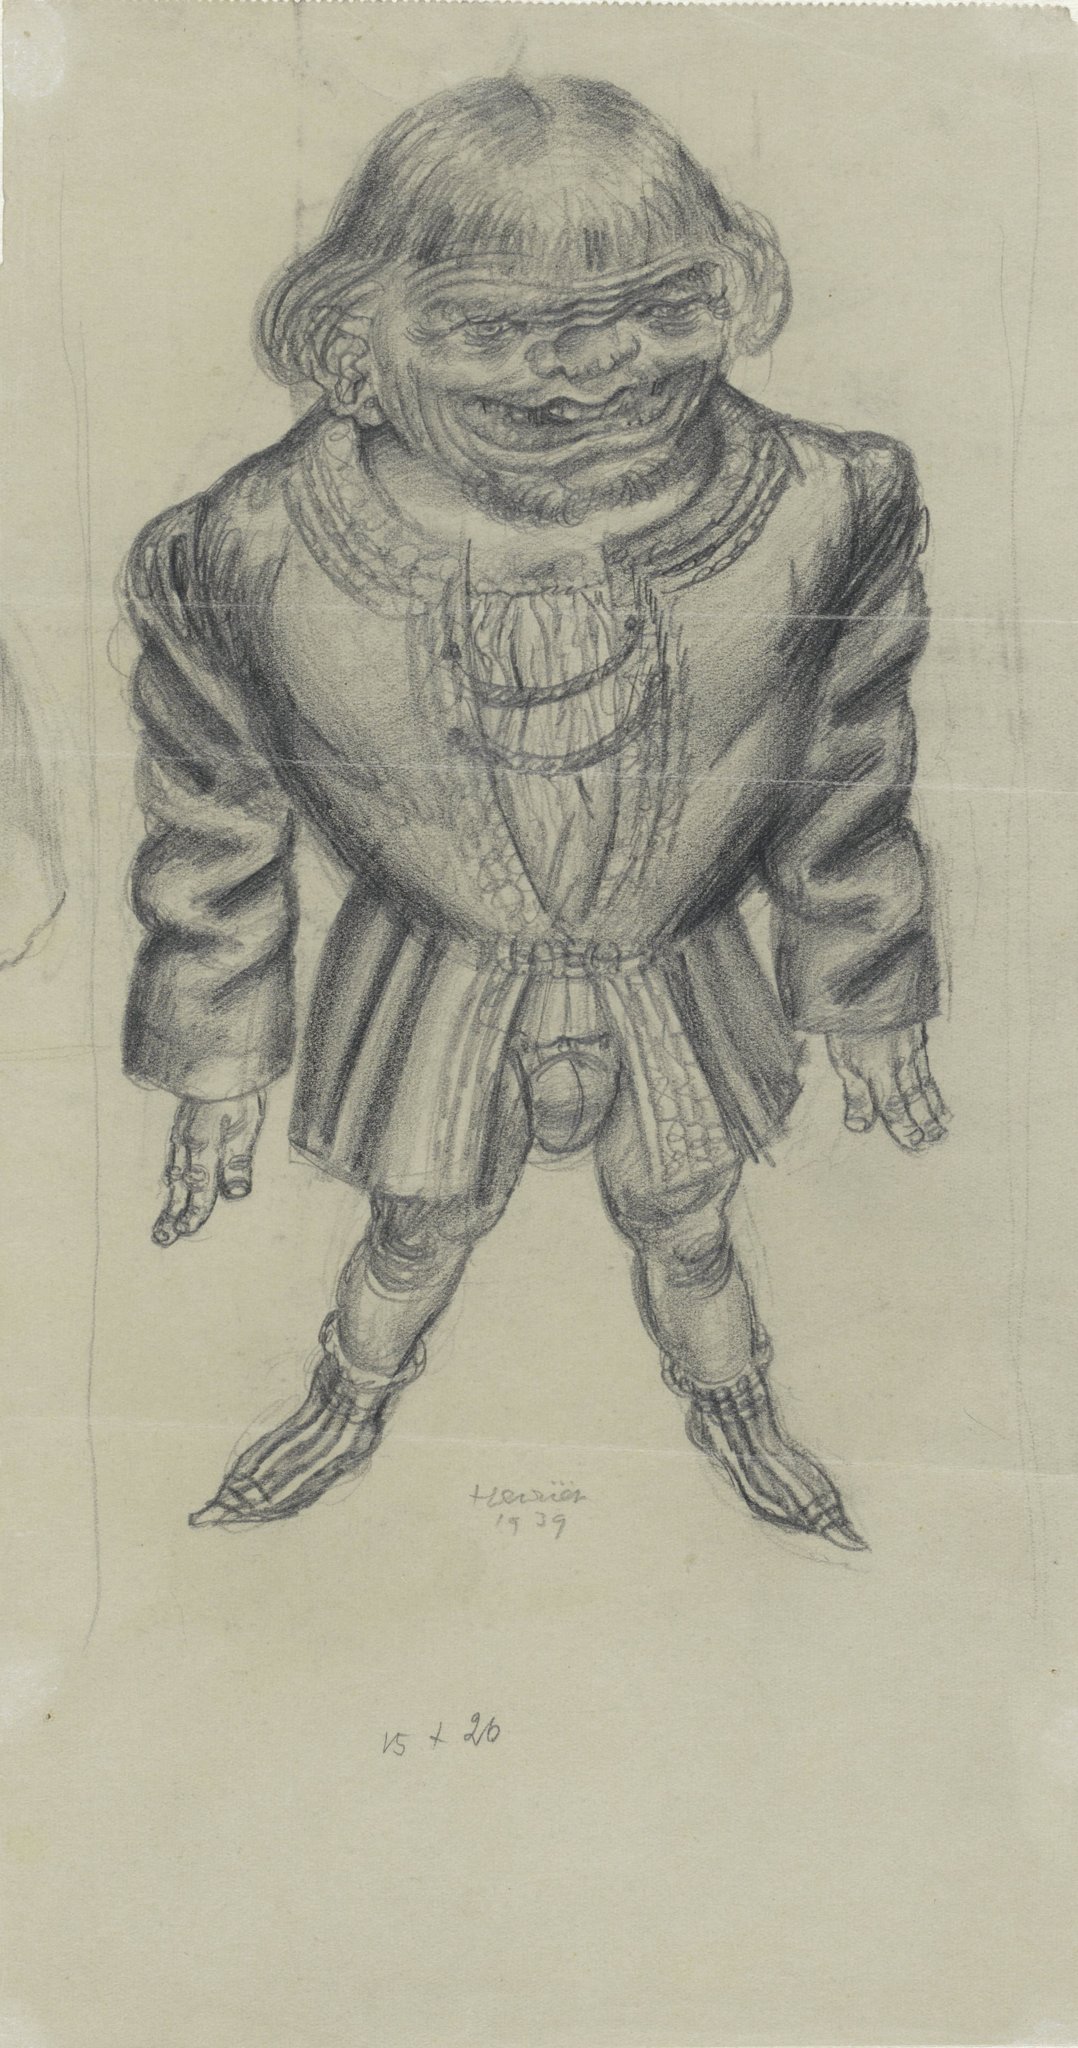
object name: drawing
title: Grandgousier staand en schreeuwend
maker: henk henriët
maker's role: draughtsman, print maker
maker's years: 1903-1945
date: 1939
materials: paper, pencil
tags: adult man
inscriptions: inscription: ‘15x20’, collector's mark: Lugt 2228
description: Deze tekening is mogelijk een ontwerp voor een illustratie bij het boek 'Gargantua en Pantagruel' van François Rabelais..